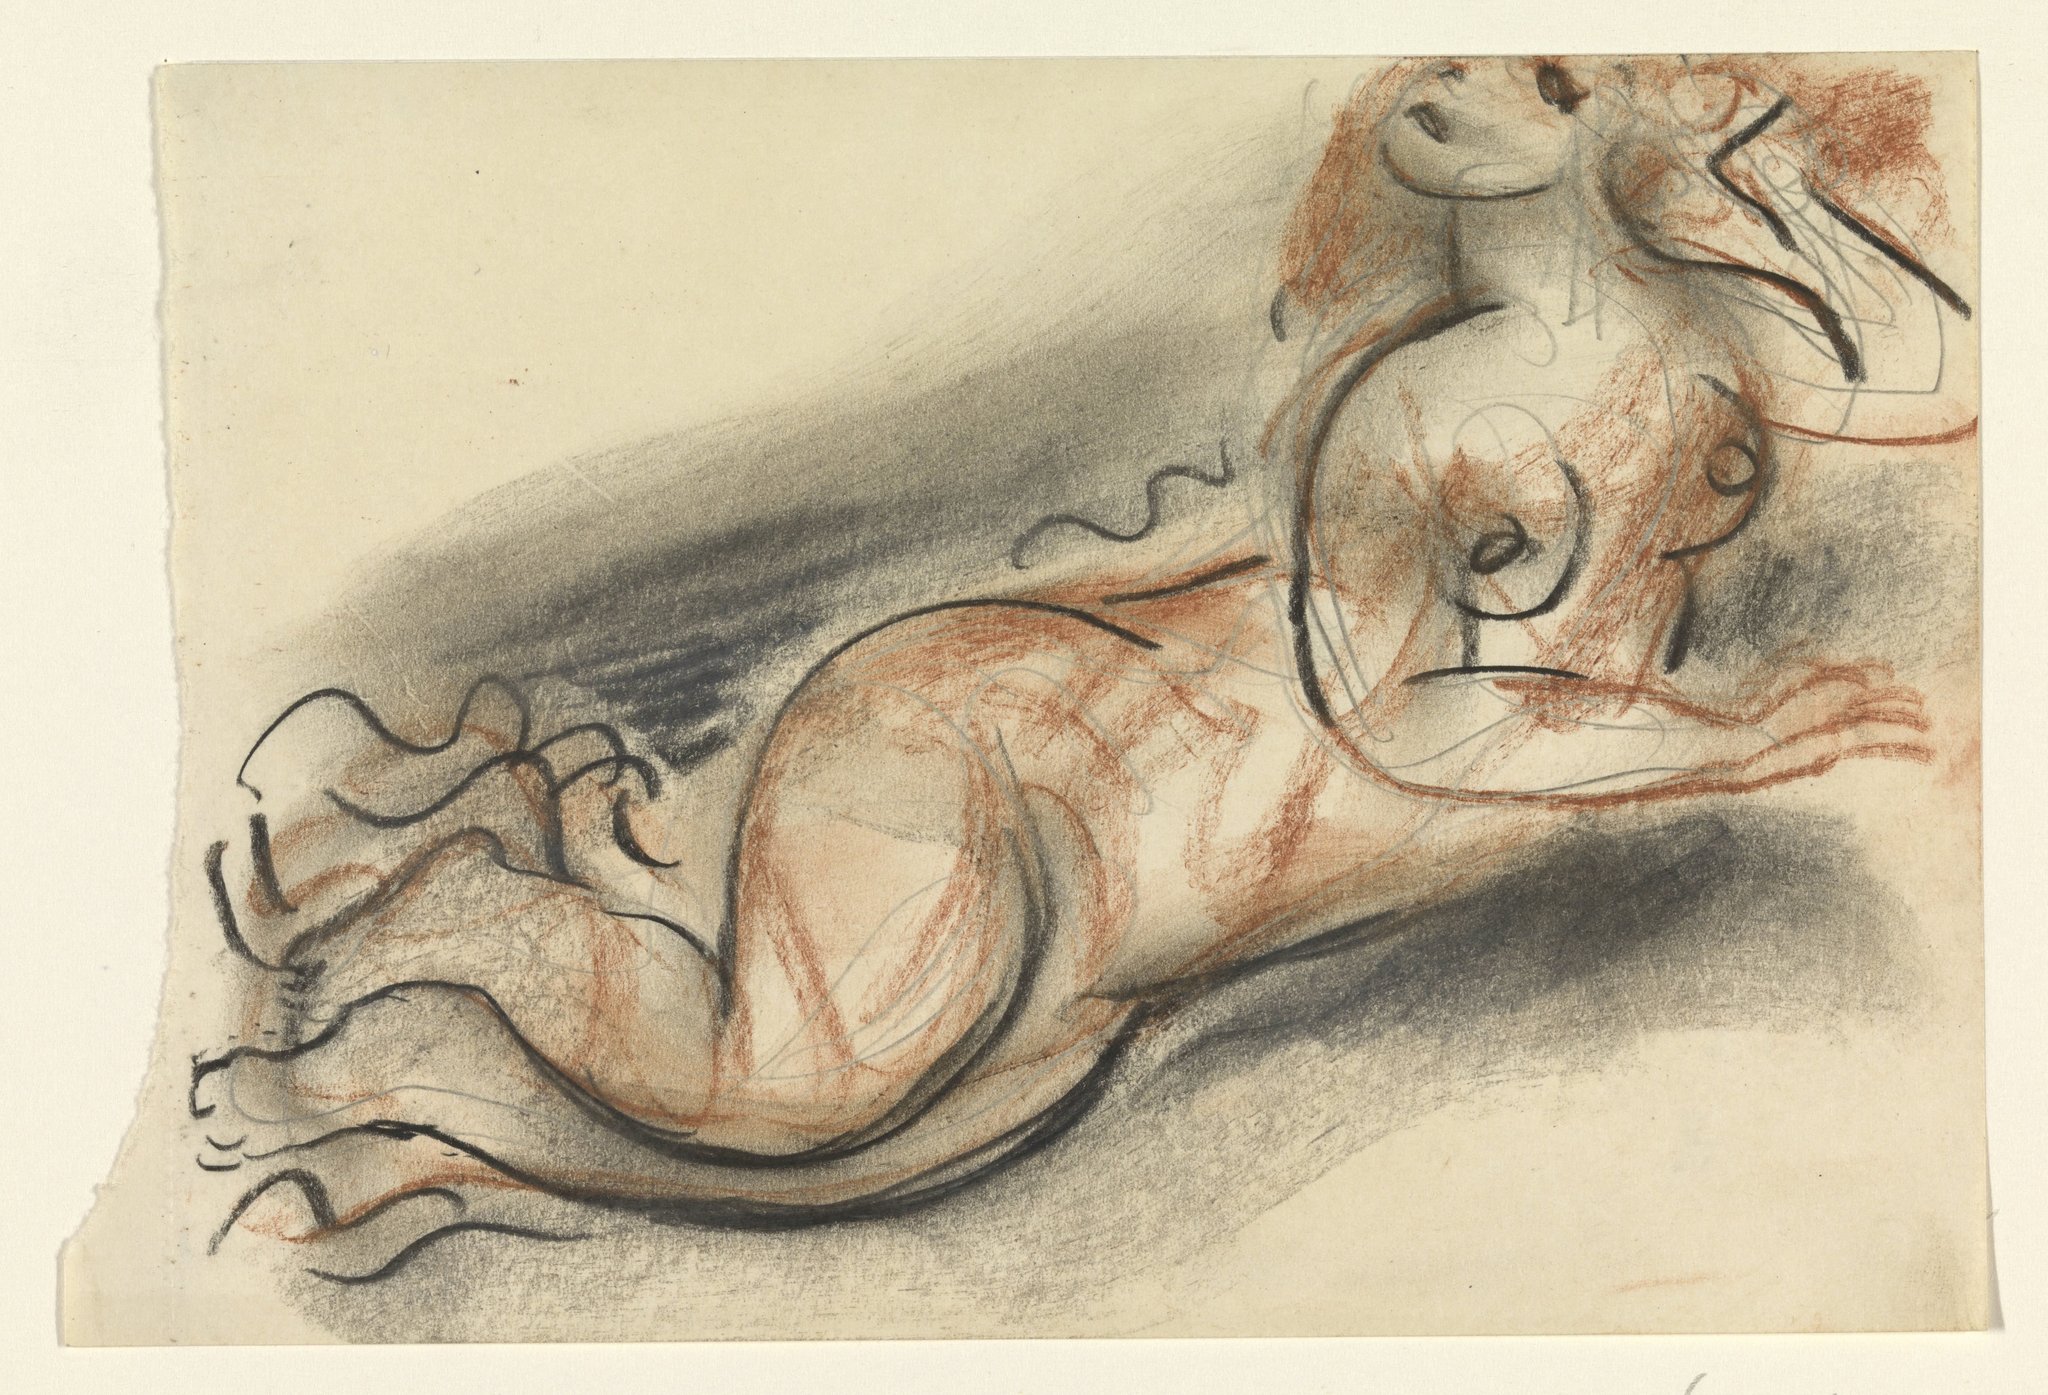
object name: drawing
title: Liggende naakte vrouw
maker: leo gestel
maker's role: draughtsman, print maker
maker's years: 1881-1941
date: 1891-1941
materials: chalk, paper, pencil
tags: lying on one side, with uplifted upper part of the body and leaning on the arm - aa - female human figure (+ nude human being)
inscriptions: collector's mark: Lugt 2228